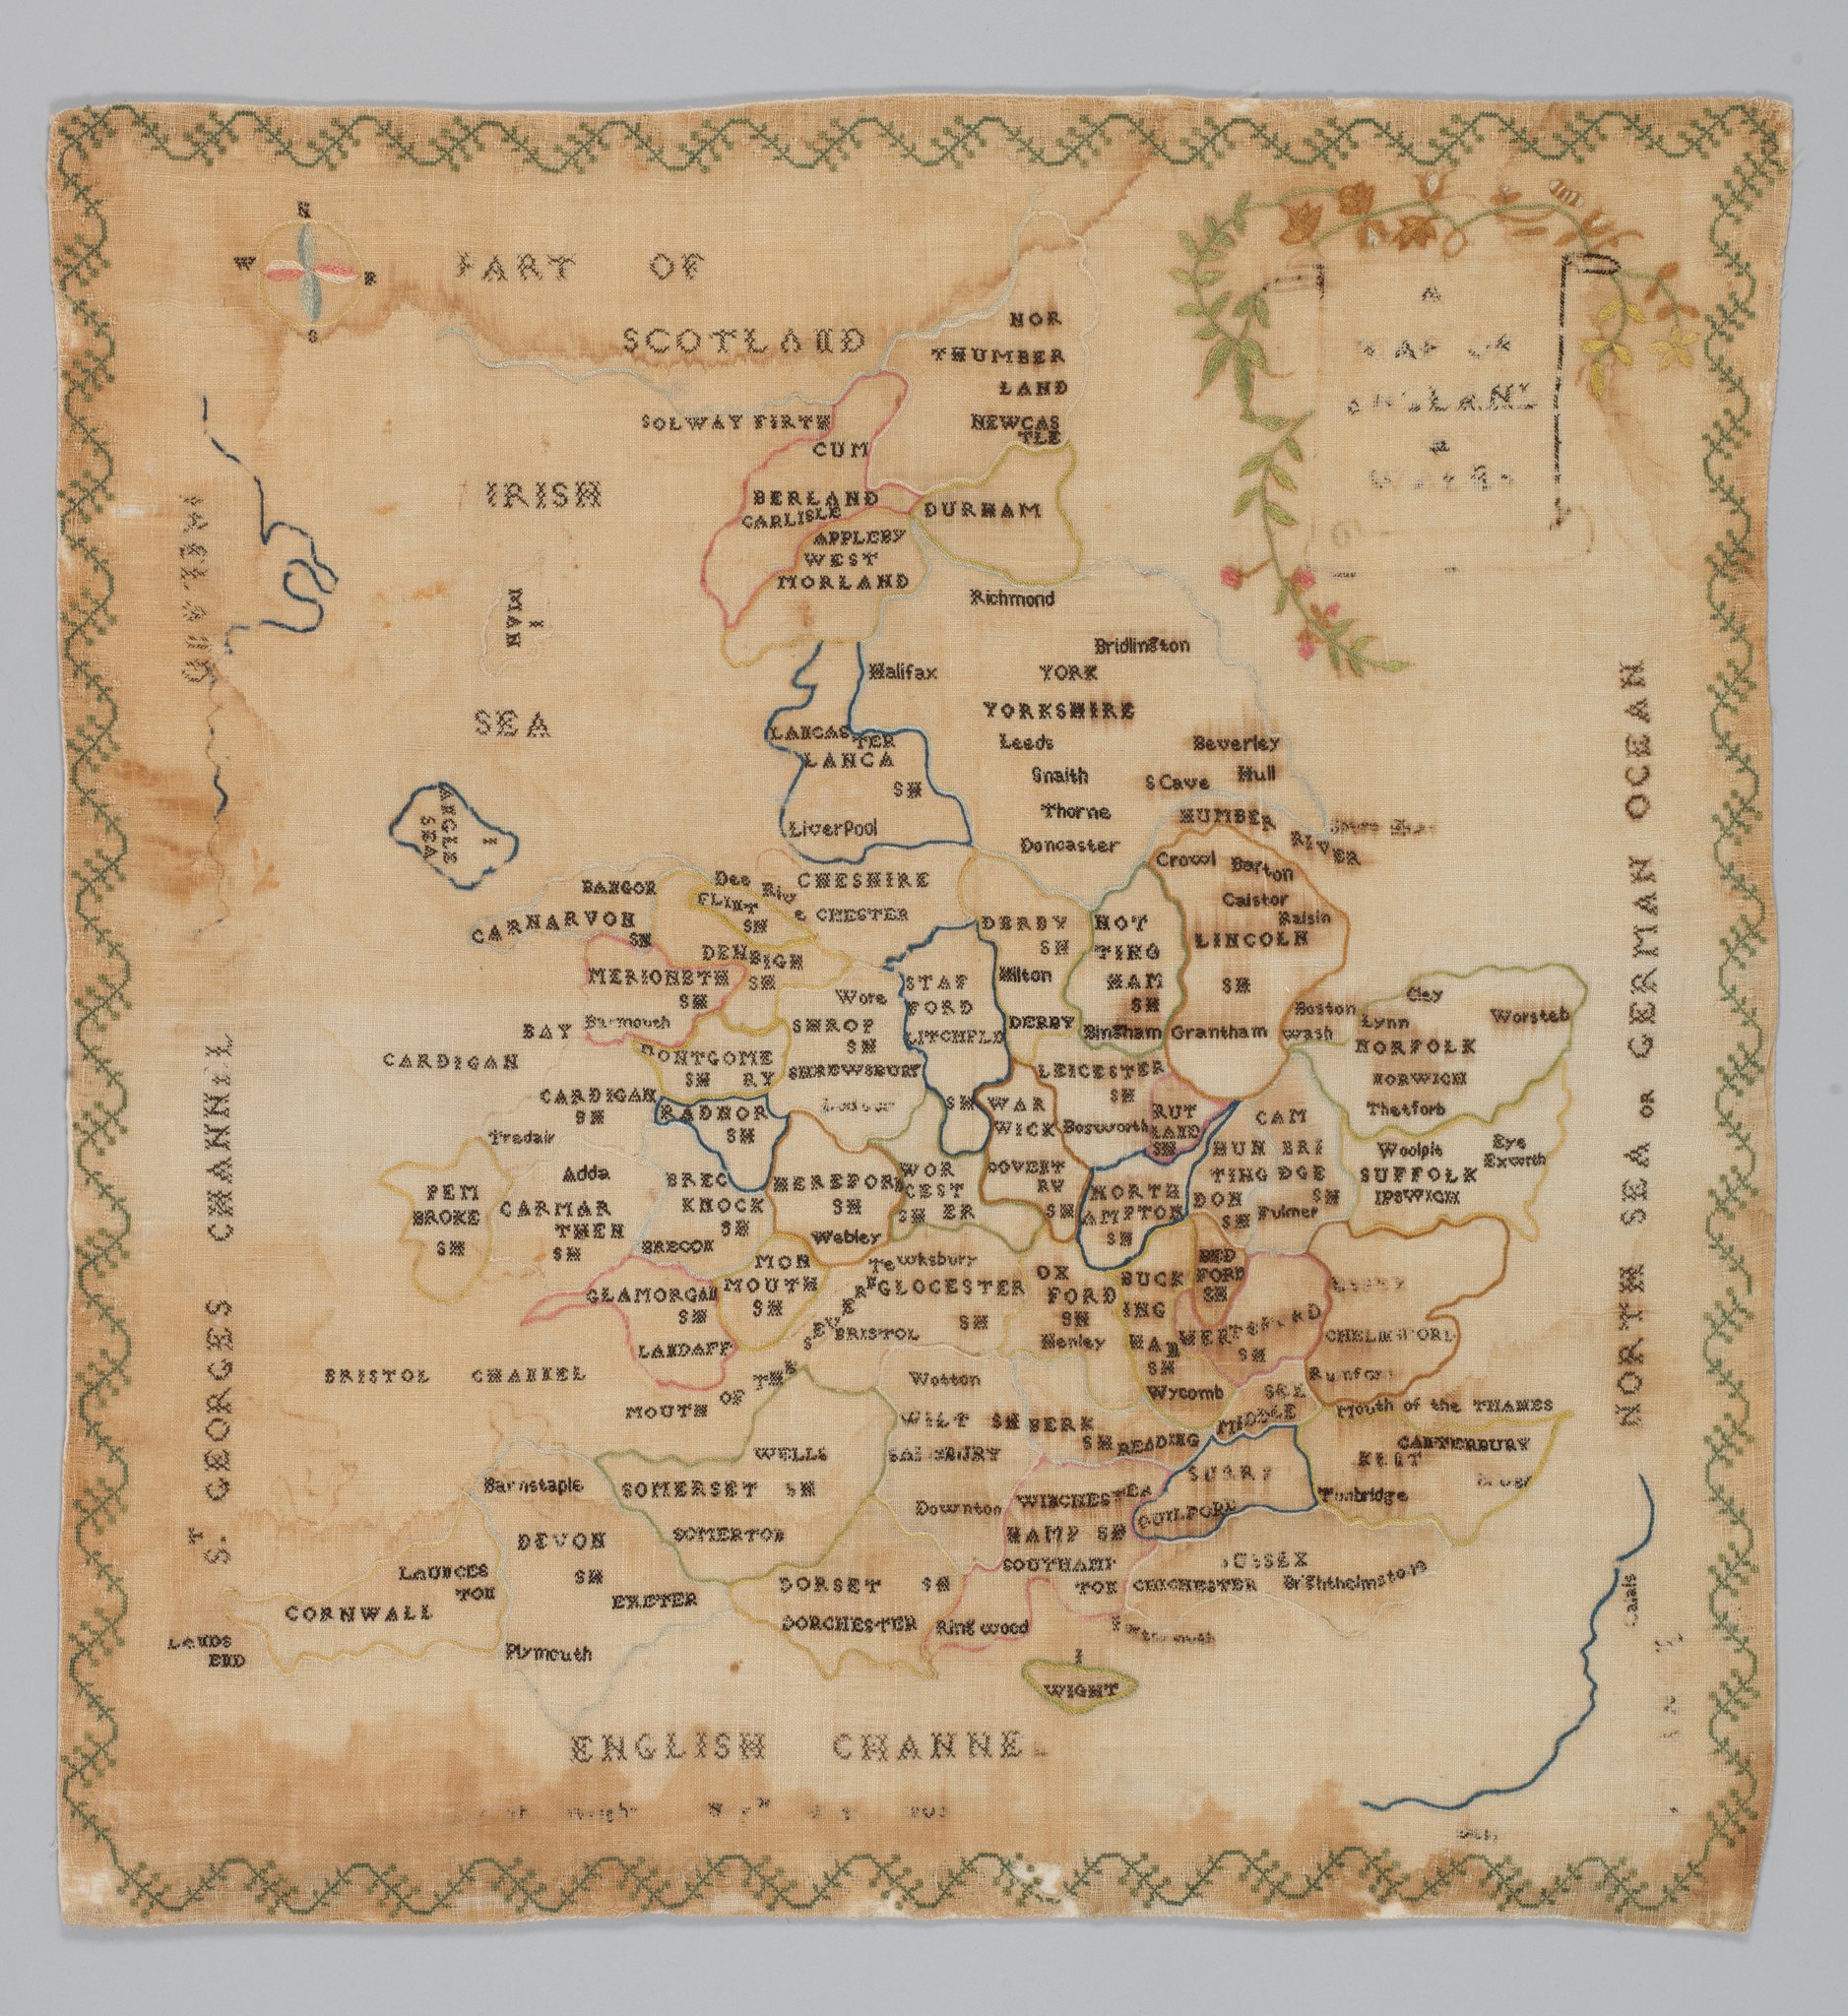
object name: sampler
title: Embroidered map sampler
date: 1801-1900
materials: canvas, cotton, silk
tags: maps